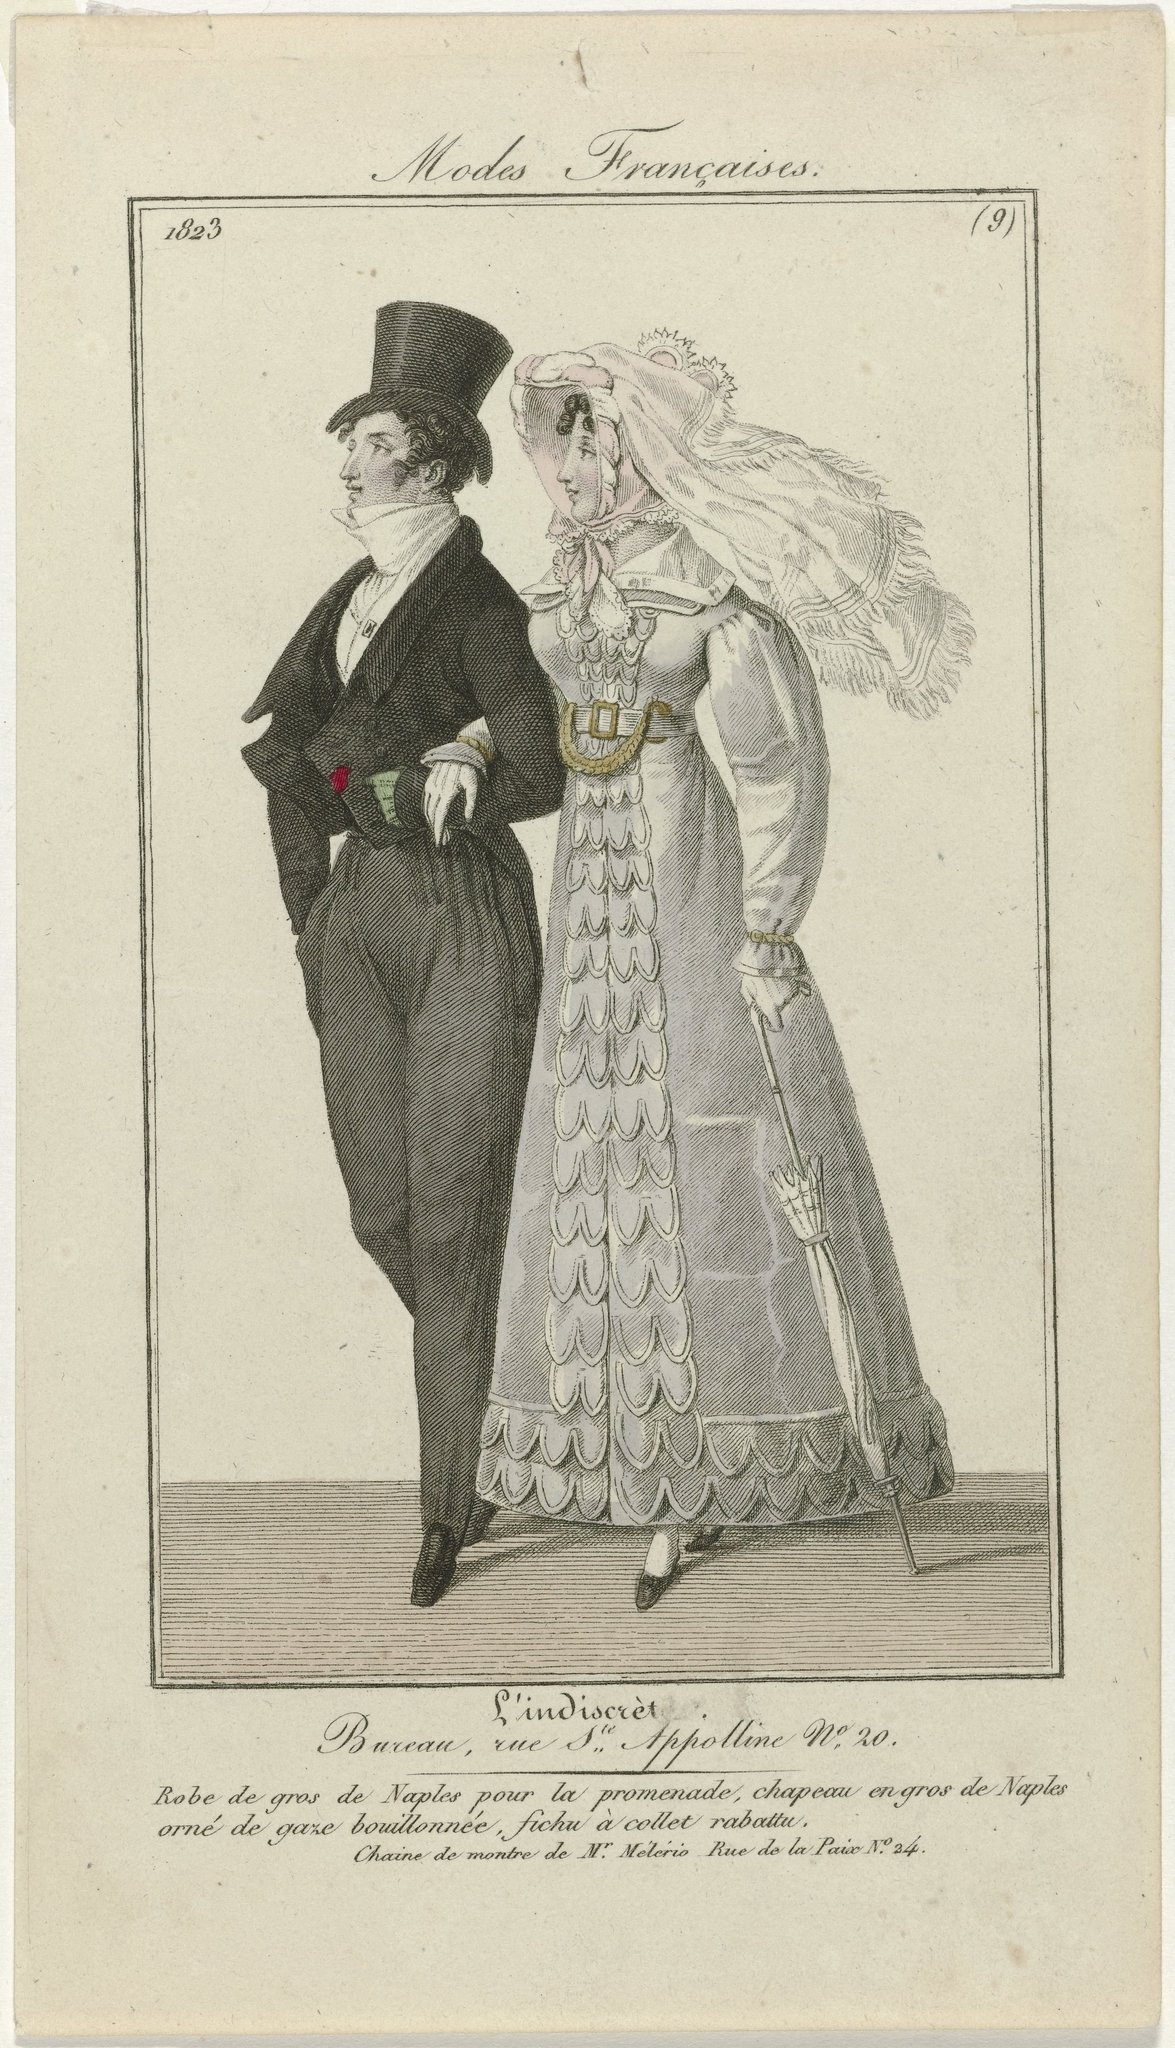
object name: fashion print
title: L'Indiscret, 1823, Modes Françaises, No. 9 : Robe de gros de Naples (...)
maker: Anonymous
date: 1823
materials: paper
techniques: engraving, hand coloring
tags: neck-gear ~ clothing (+ men's clothes), veil (+ women's clothes), dress, gown: walking dress (+ women's clothes), trousers, breeches, etc. (pantalon) (+ men's clothes), head-gear (+ women's clothes), neck-gear: collar (+ women's clothes), fashion plates, piece of clothing covering the breast or décolleté (fichu) (+ women's clothes), parasol, sunshade (+ women's clothes)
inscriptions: caption: ‘Robe de gros de Naples pour la promenade, chapeau en gros de Naples orné de gaze bouillonnée, fichu à collet rabattu.’, title: ‘L'indiscrèt’, title: ‘Modes Françaises.’, address: ‘Bureau, rue Ste.Appolline No. 20’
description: Man en vrouw lopen gearmd. Wandeljapon van 'gros de Naples'. Hoed van gros de Naples', versierd met 'gaze bouillonnée'. Fichu met neergeslagen kraag. Verdere accessoires: ceintuur met gesp, parasol, schoenen. Hij draagt een frak, vest en een lange broek. Prent uit het modetijdschrift L'Indiscret (april 1823-december 1823).